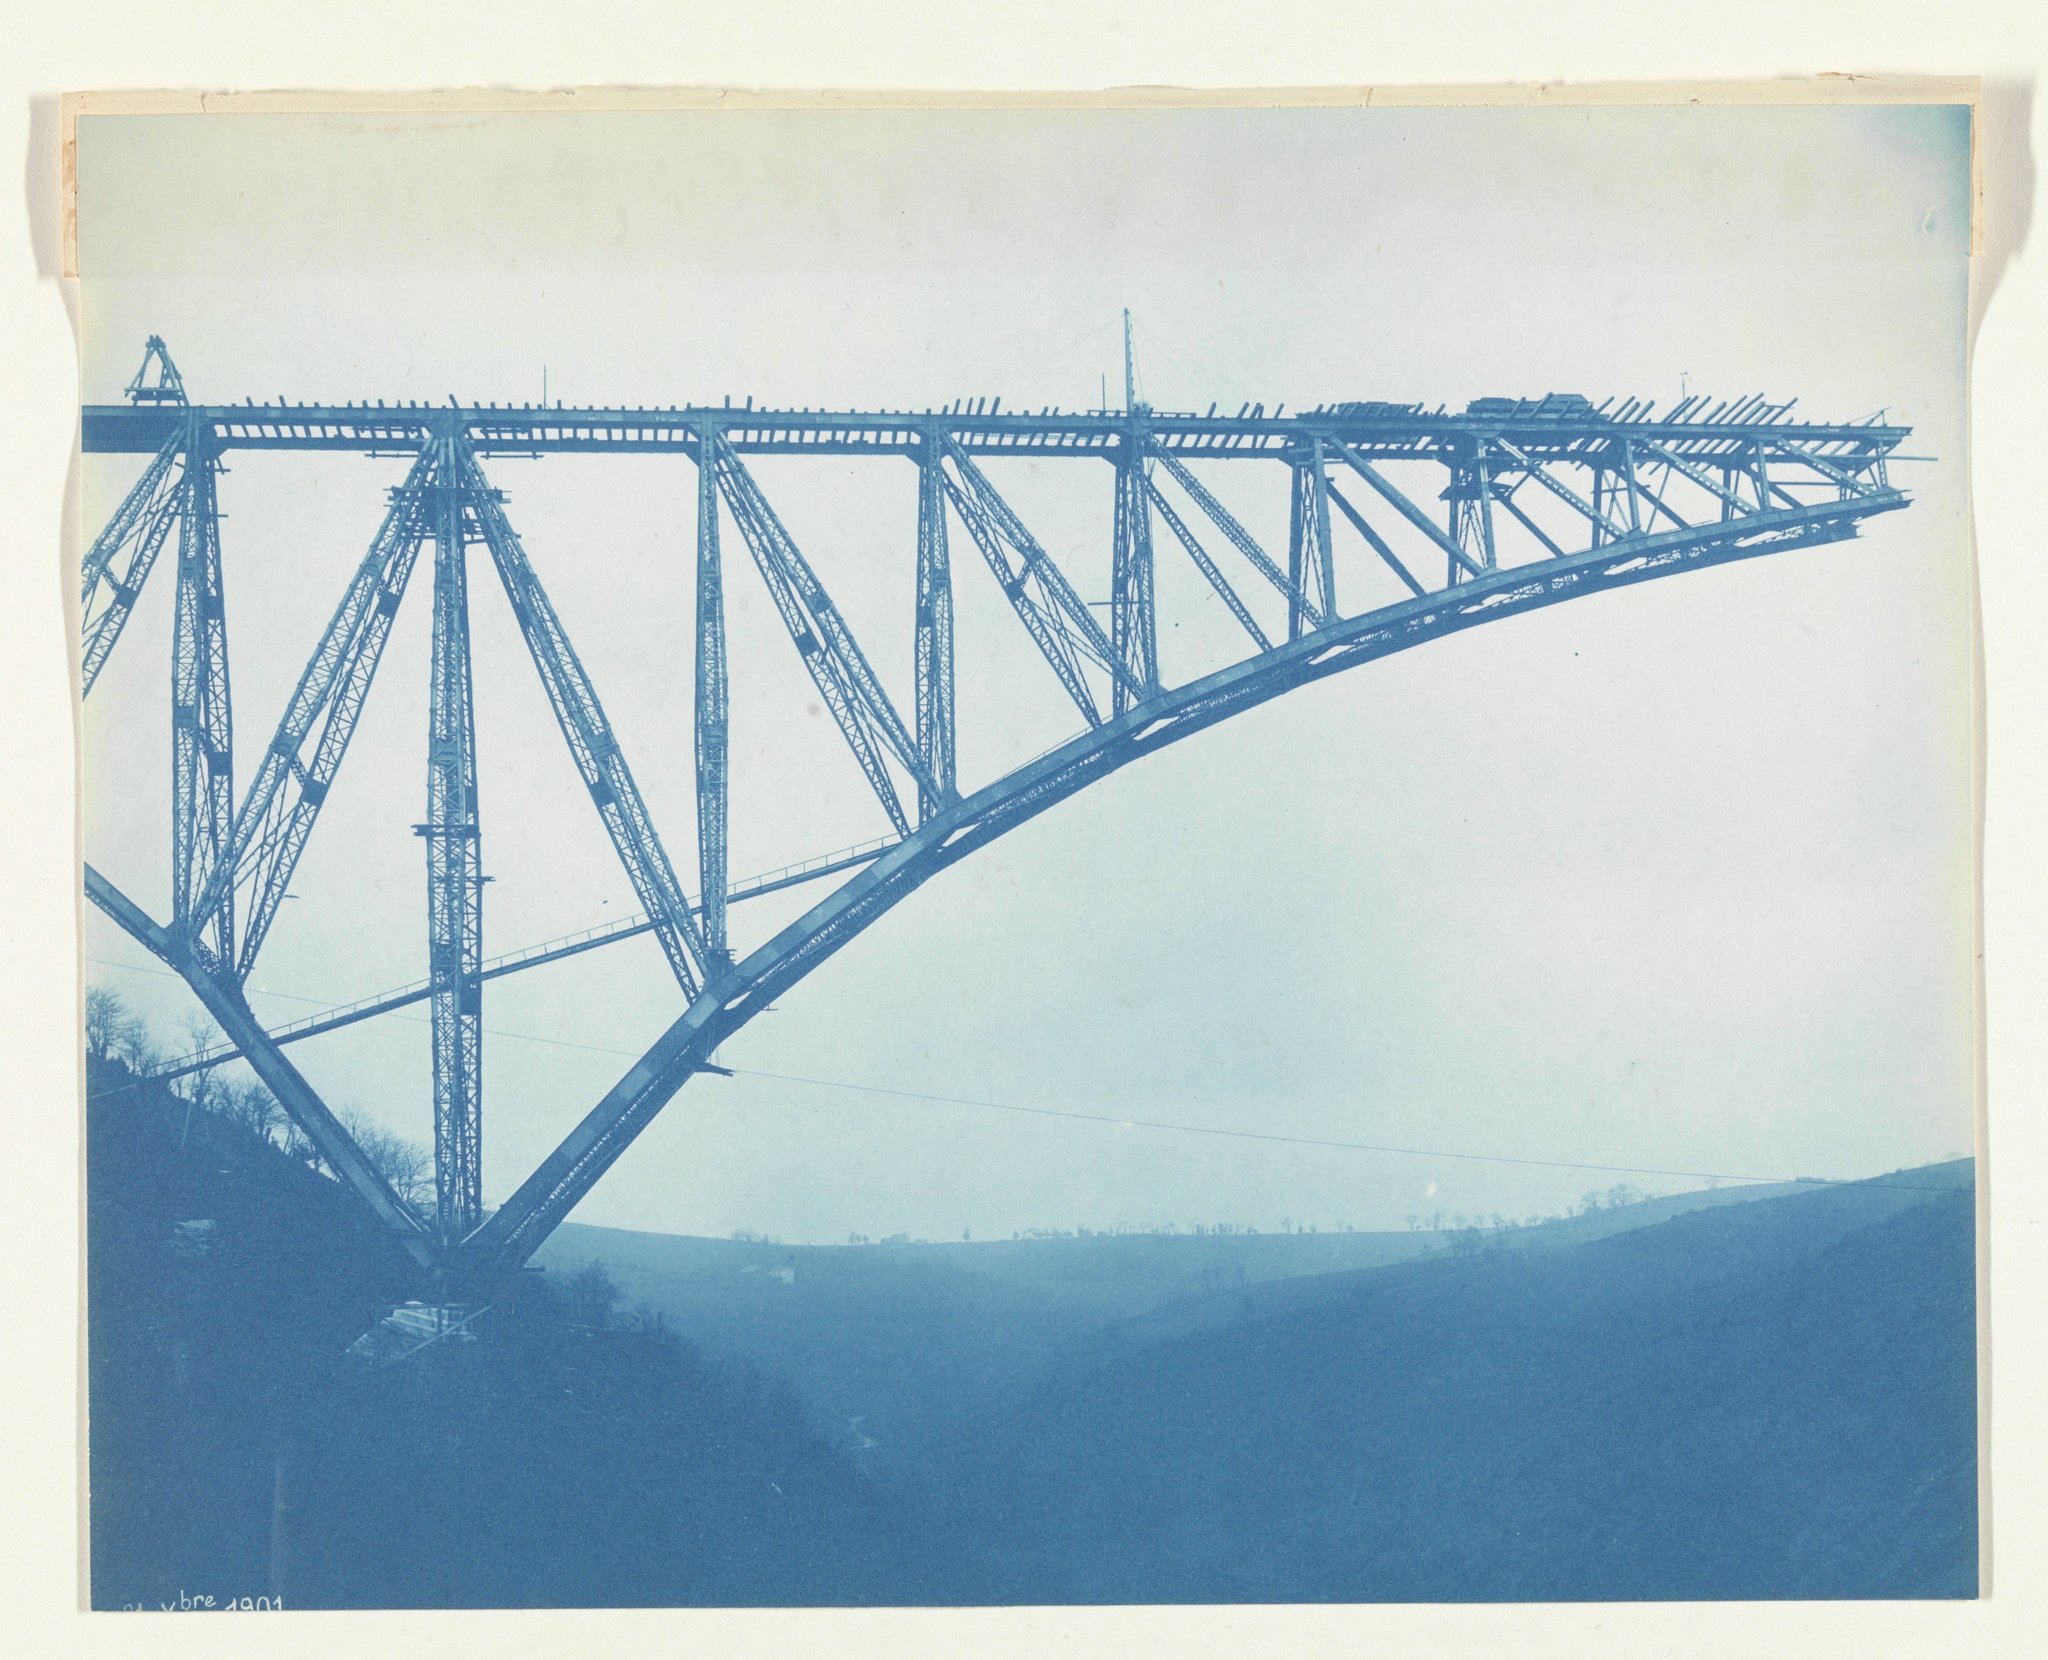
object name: photograph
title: Construction of the Viaur Viaduct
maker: Anonymous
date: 1901-1911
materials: photographic support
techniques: cyanotype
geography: france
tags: viaduct, making the overground structures (~ building activities)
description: In their time these modern looking photographs were nothing more than simple tools. The architectural draughtsmen of the viaduct would consult them when discussing their work. Architects generally relied on blueprints to quickly duplicate the construction drawings. The interplay of lines of the slender structures rising high above the ground and standing out against the sky is enhanced by the powerful contrast.